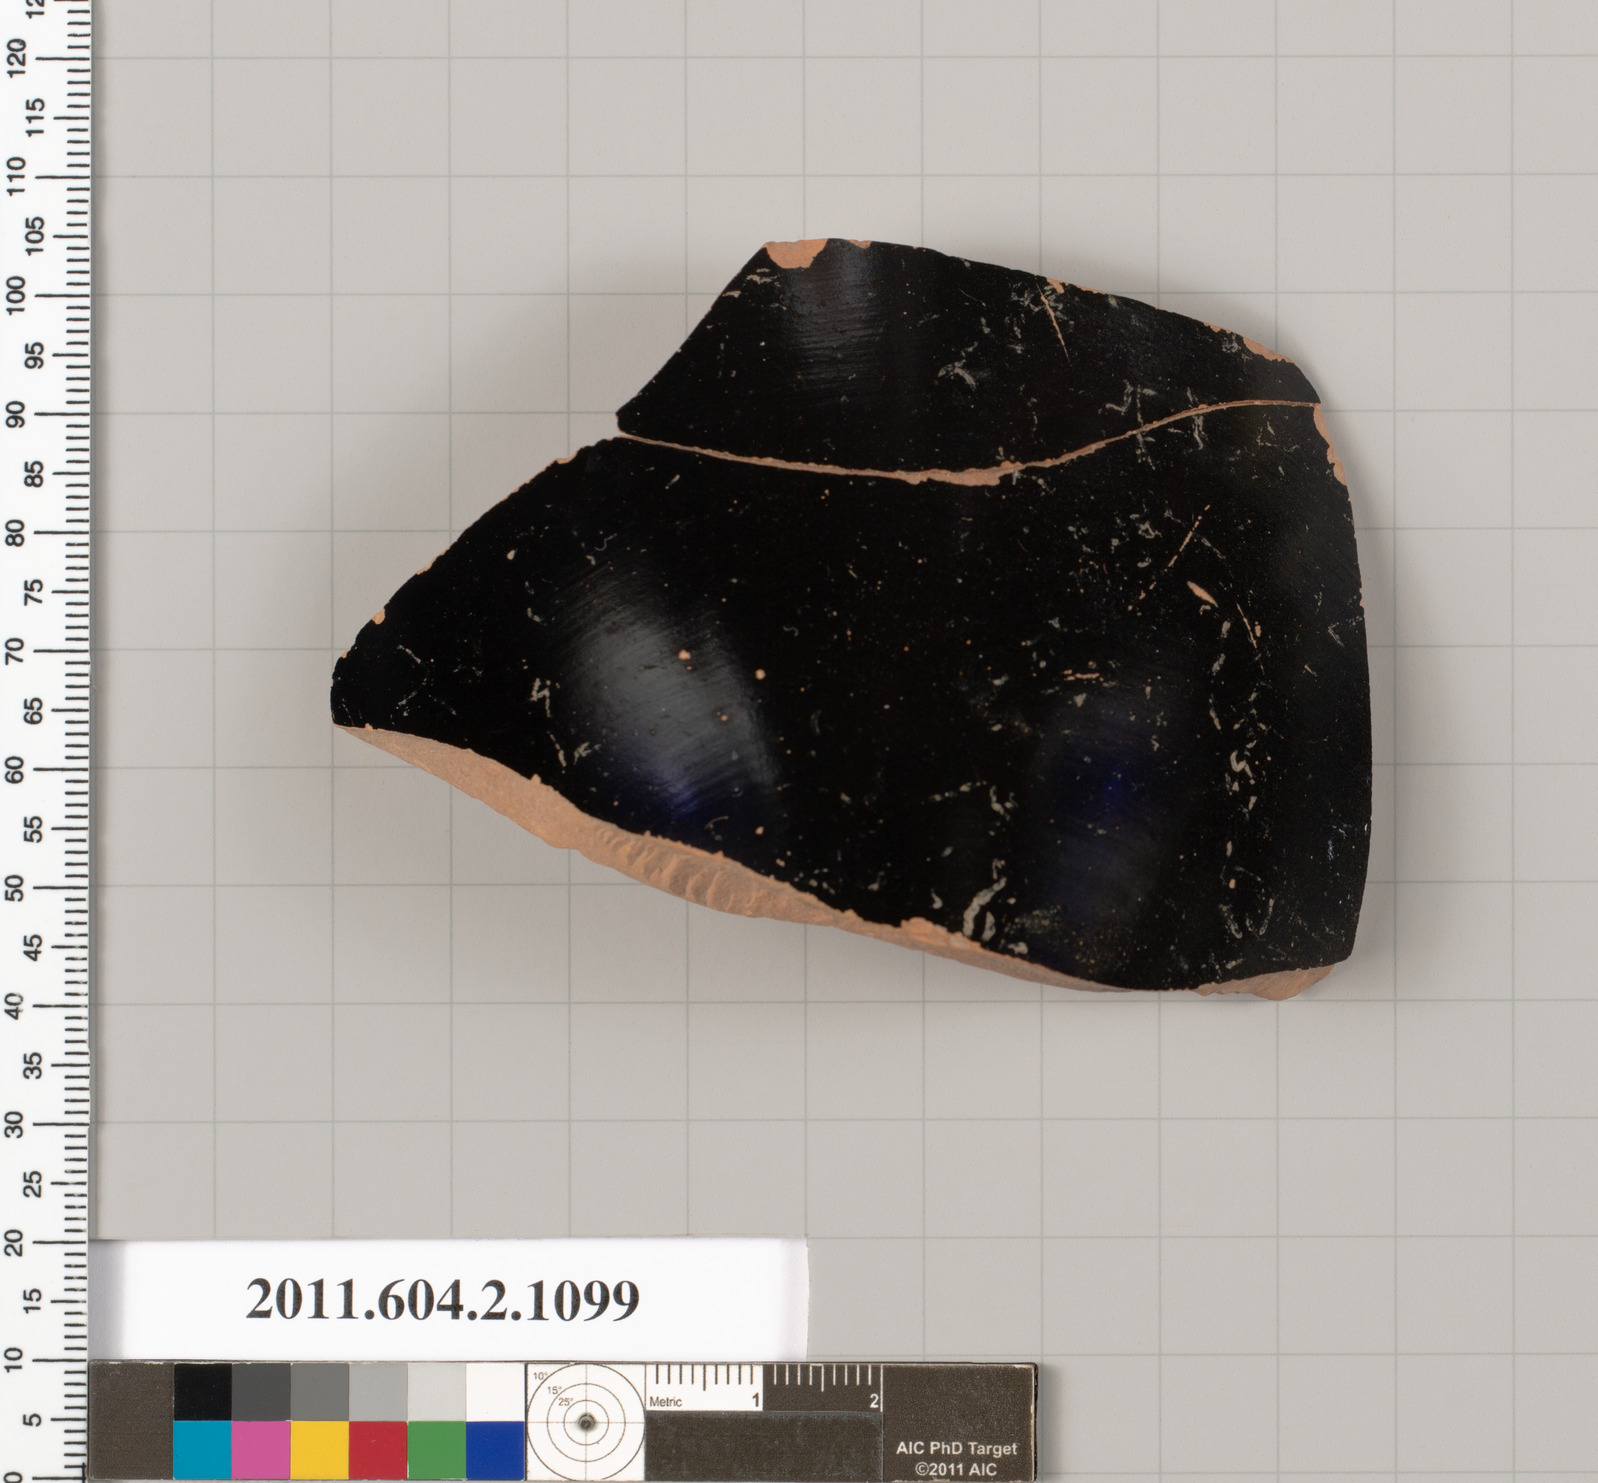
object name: lekythos fragment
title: Terracotta fragment of a squat lekythos (oil flask)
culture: greek, attic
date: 500-451 BCE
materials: terracotta